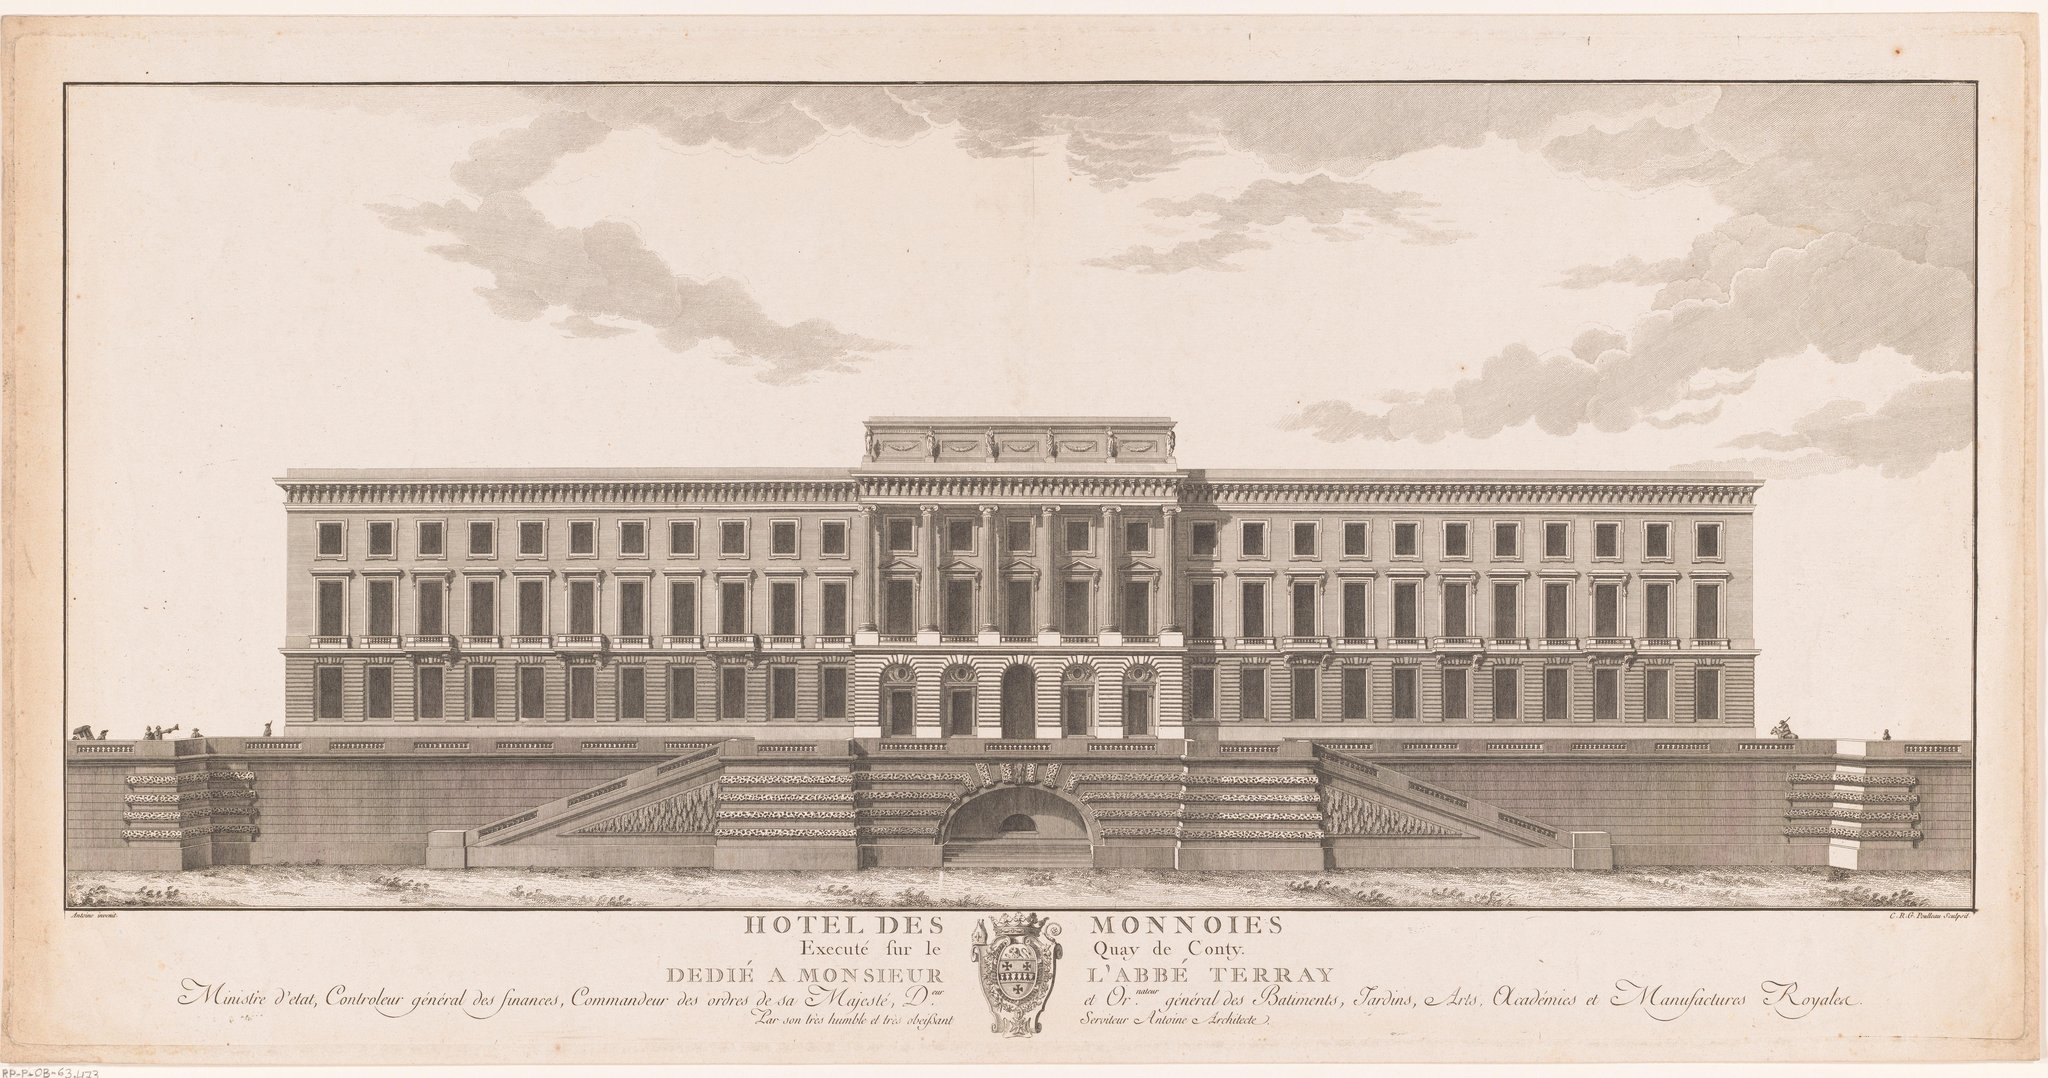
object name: print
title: Hotel des Monnoies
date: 1759-1801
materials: paper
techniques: engraving, etching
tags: hôtel, i.e. small palace in city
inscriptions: collector's mark: Lugt 2228